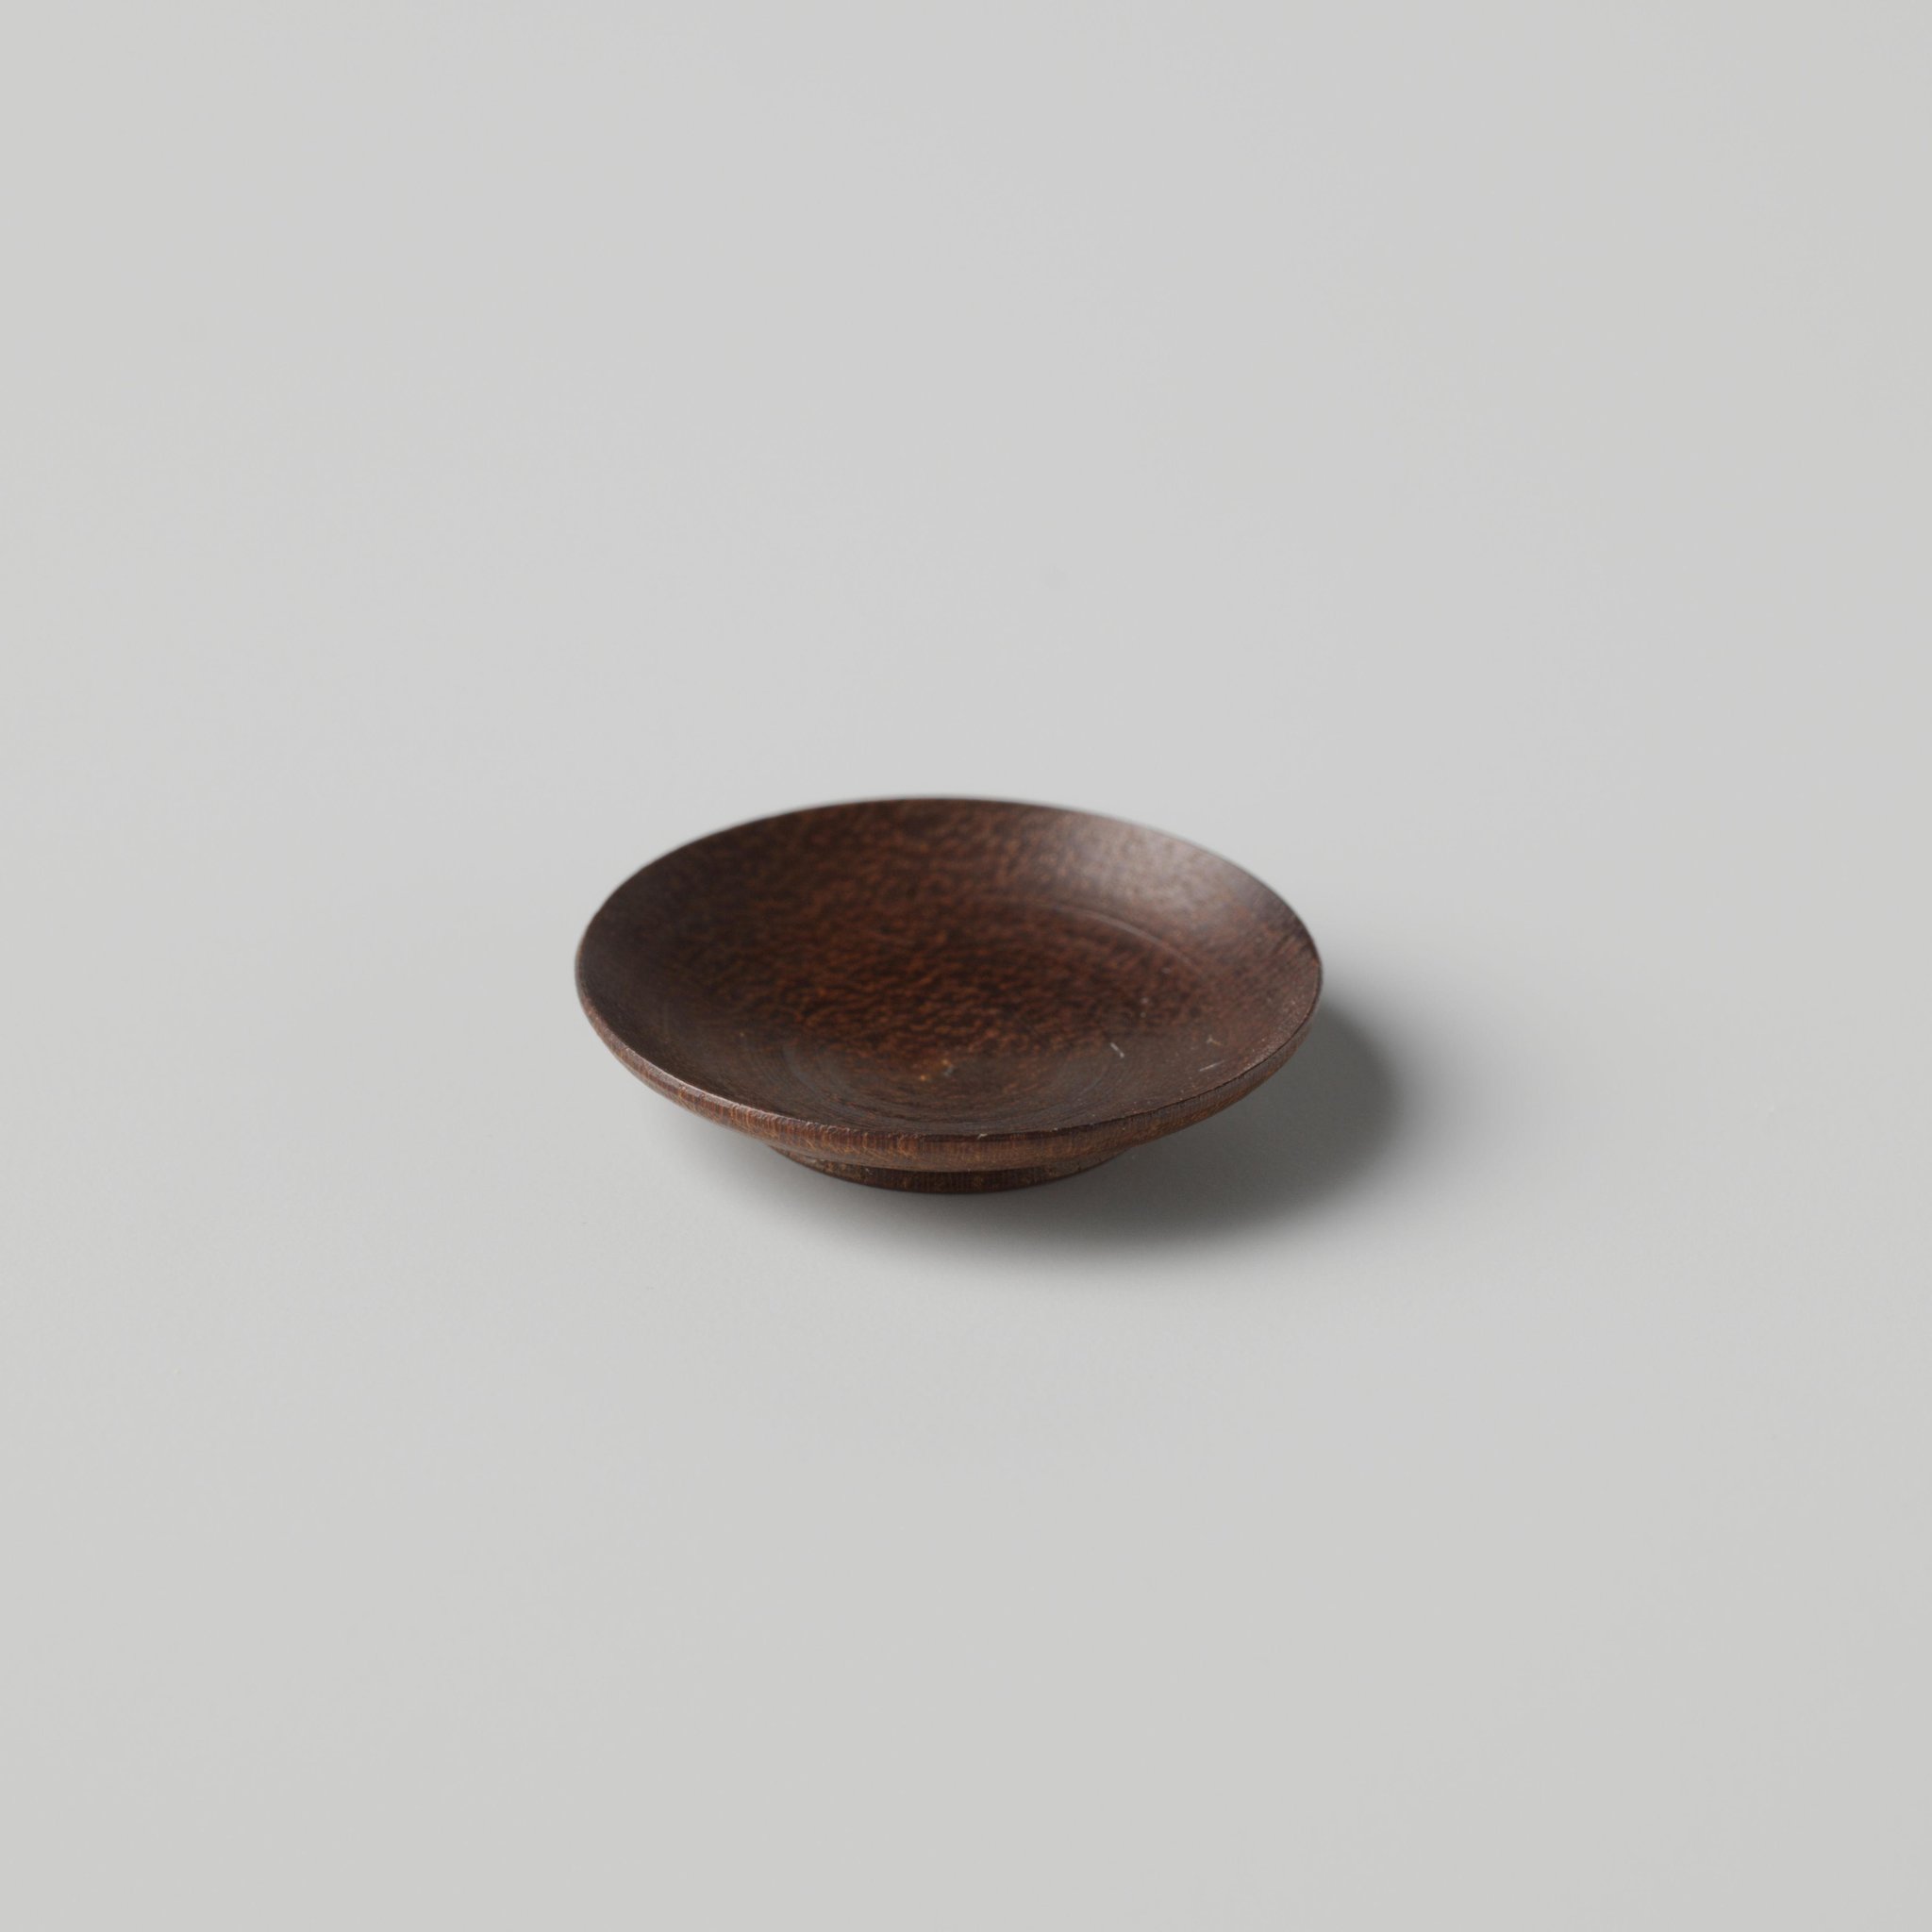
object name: miniature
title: Schotel van gedraaid hout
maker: Anonymous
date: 1800-1899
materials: wood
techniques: tropisch hardhout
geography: england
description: Schotel zonder rand, gedraaid van een donkere hardhoutsoort.